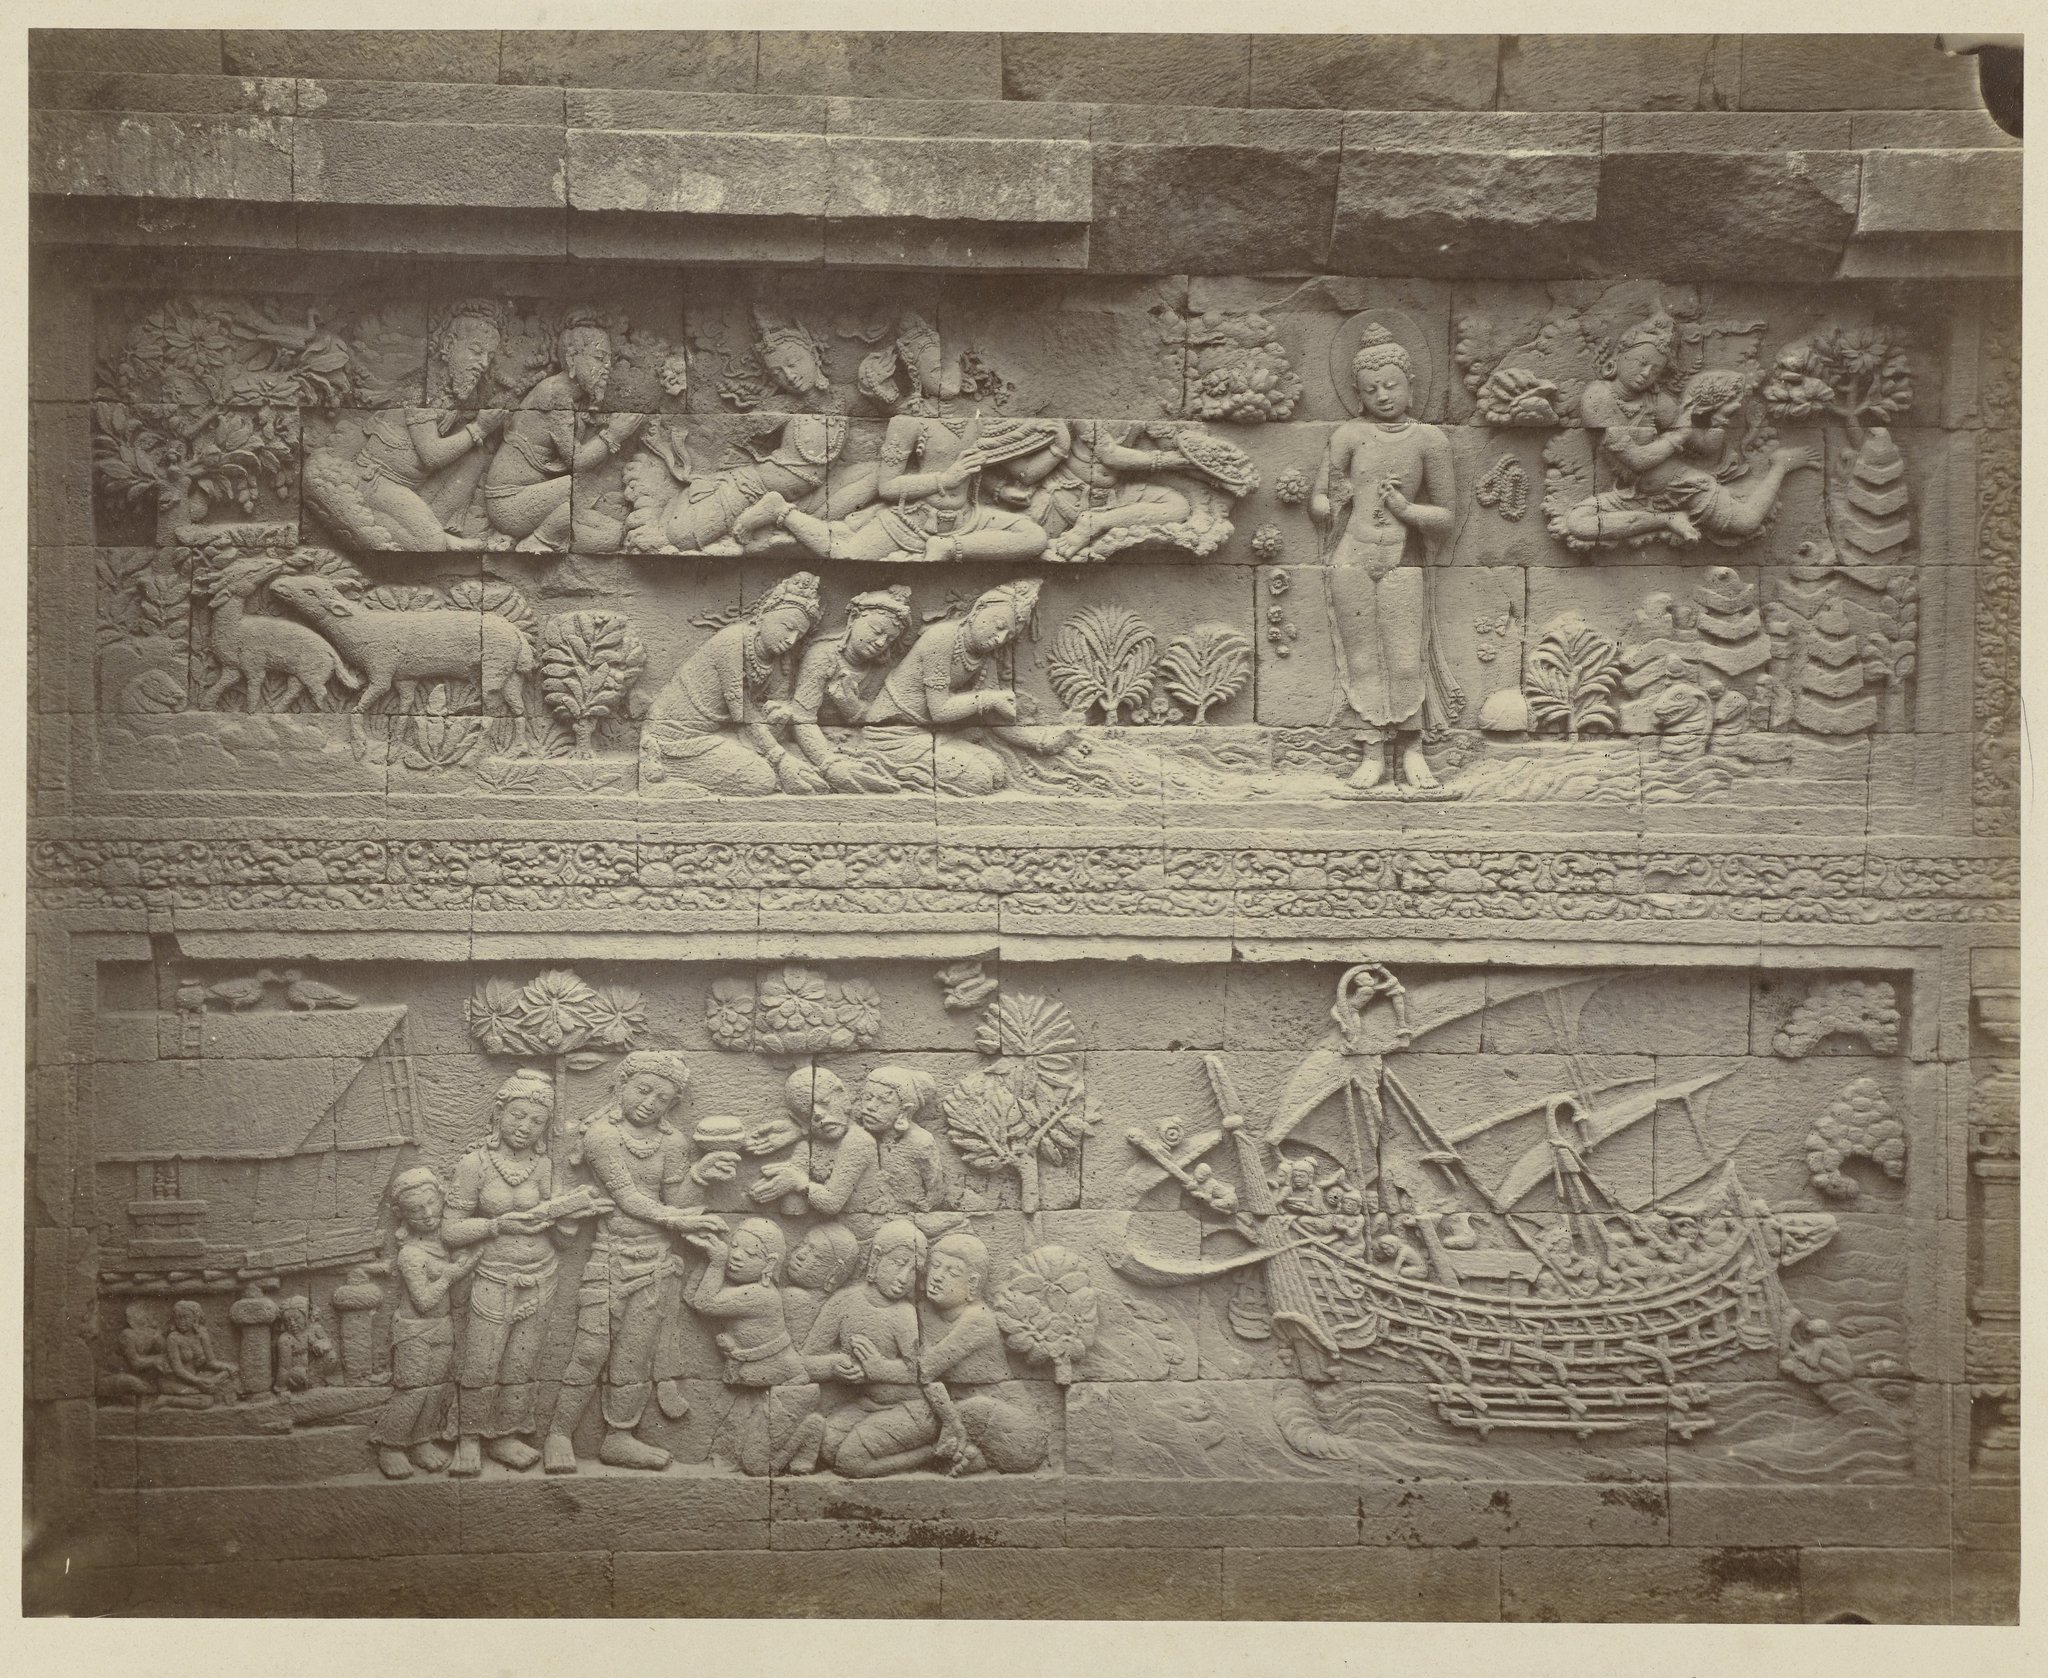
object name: photograph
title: Basreliëf in de noord muur van de Borobudur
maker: isidore kinsbergen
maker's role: fotograaf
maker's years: 1821-1905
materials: cardboard, paper, photographic support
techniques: albumen print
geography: java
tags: borobudur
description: Gallery I, main wall, north side 45 (top) relief 1a-86 Lalitavistara relief, Siddhartha bathing. 46 (bottom); relief 1b-86 Avadana relief, Rudrayana story. Hiru, the former advisor of King Rudrayana, arriving at the future Hiruka settlement. Borobudur village, Magelang district, Central Java province, 778-824 AD.